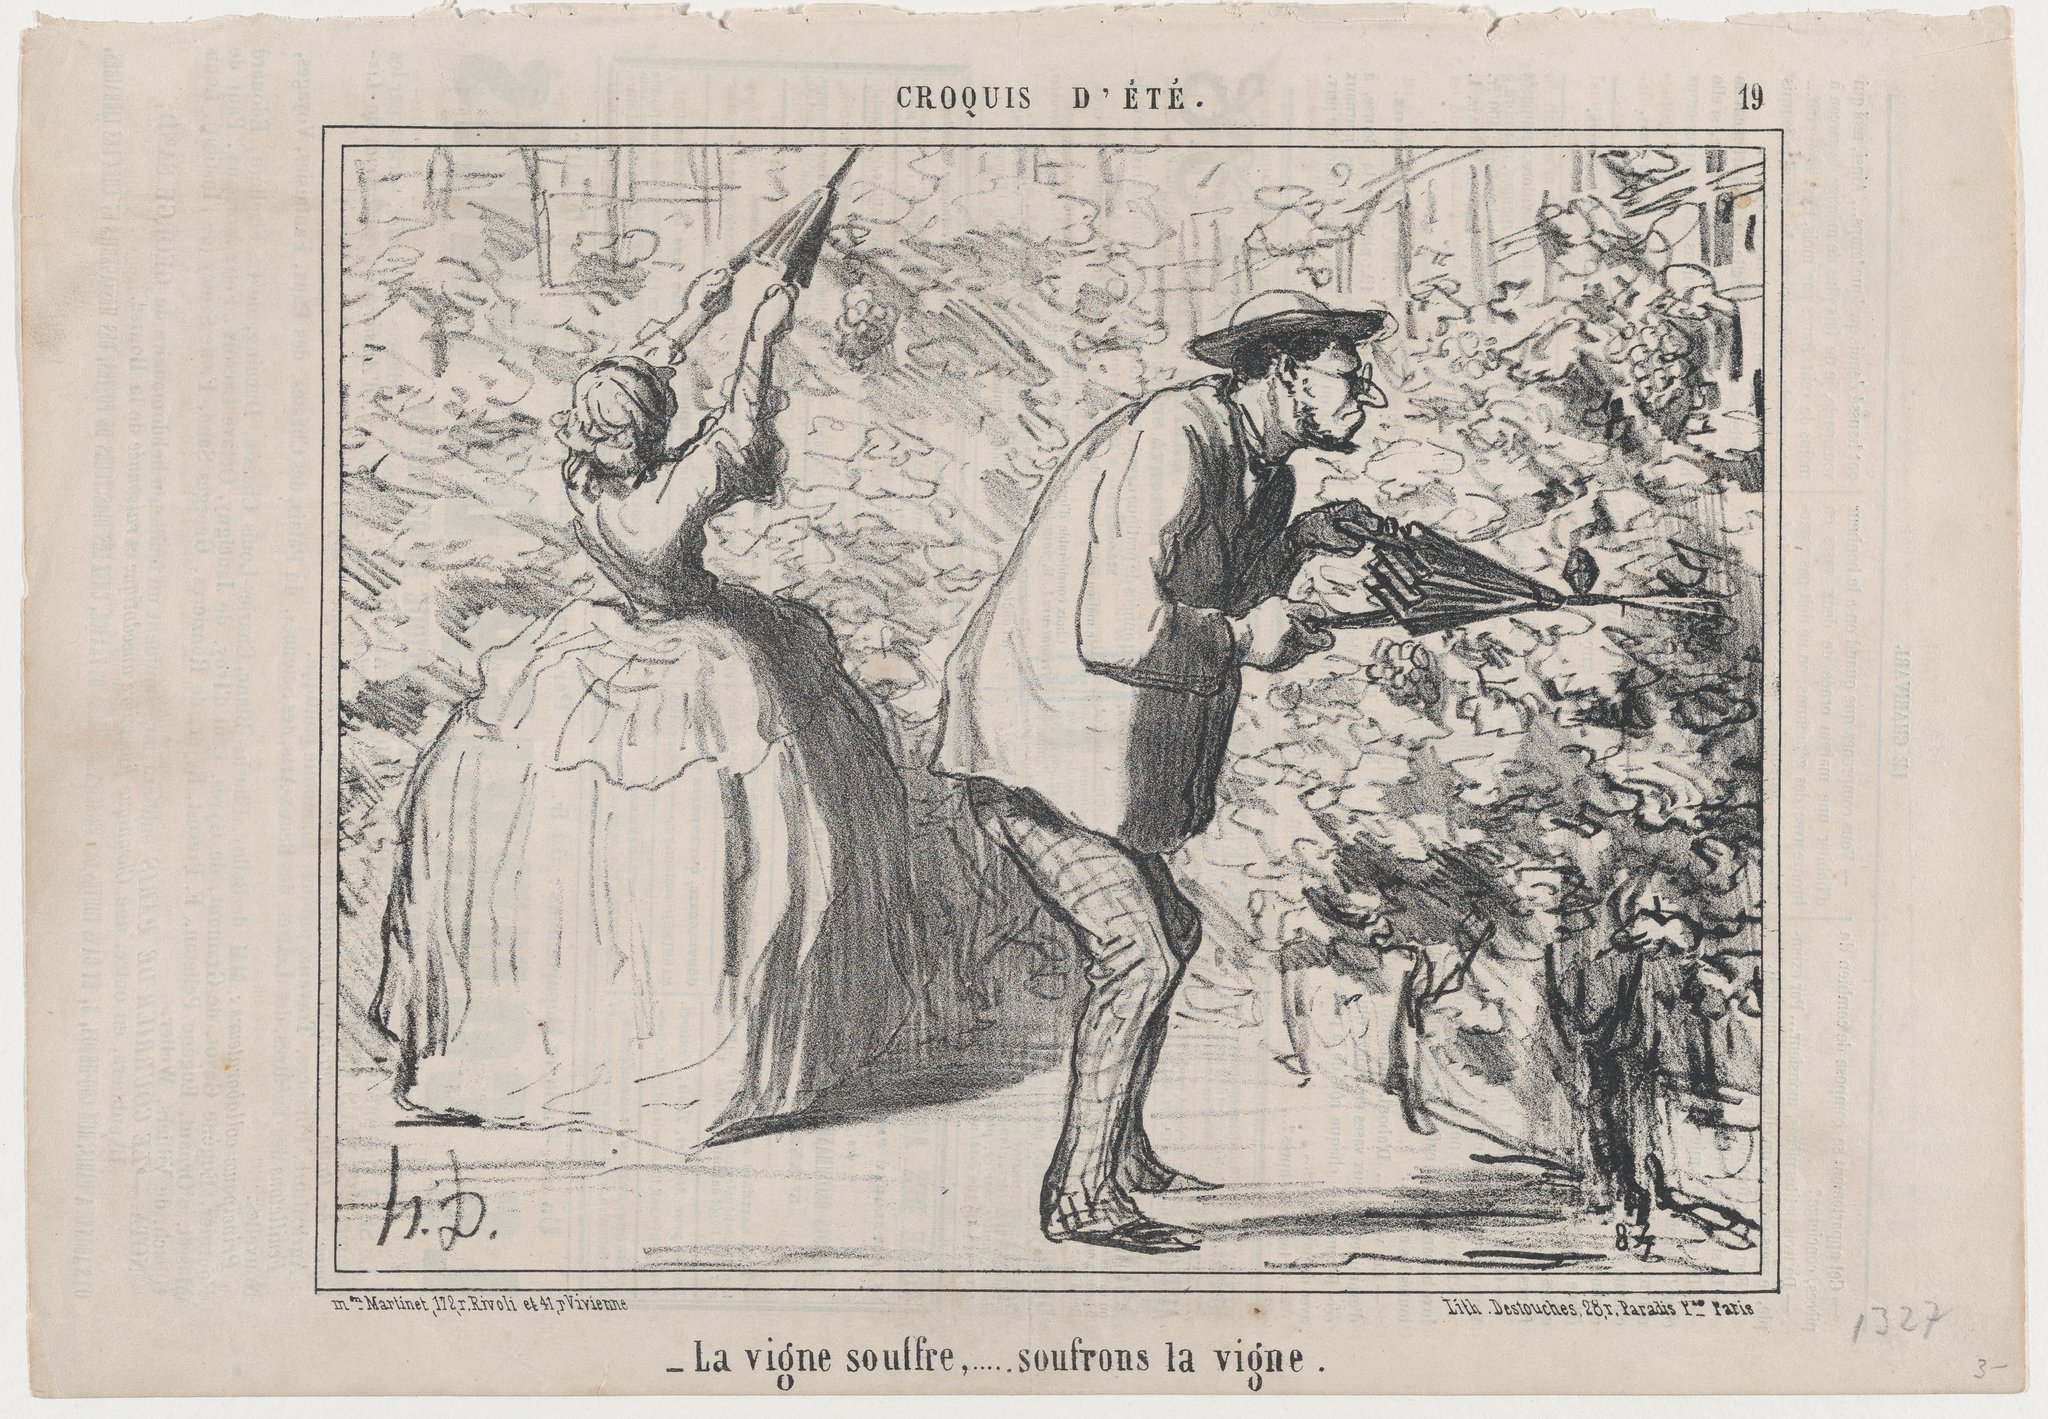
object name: print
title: La vigne souffre,... soufrons la vigne, from "Croquis d'Été"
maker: honoré daumier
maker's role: artist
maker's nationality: french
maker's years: 1808-1879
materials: paper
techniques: lithograph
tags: men,women,working